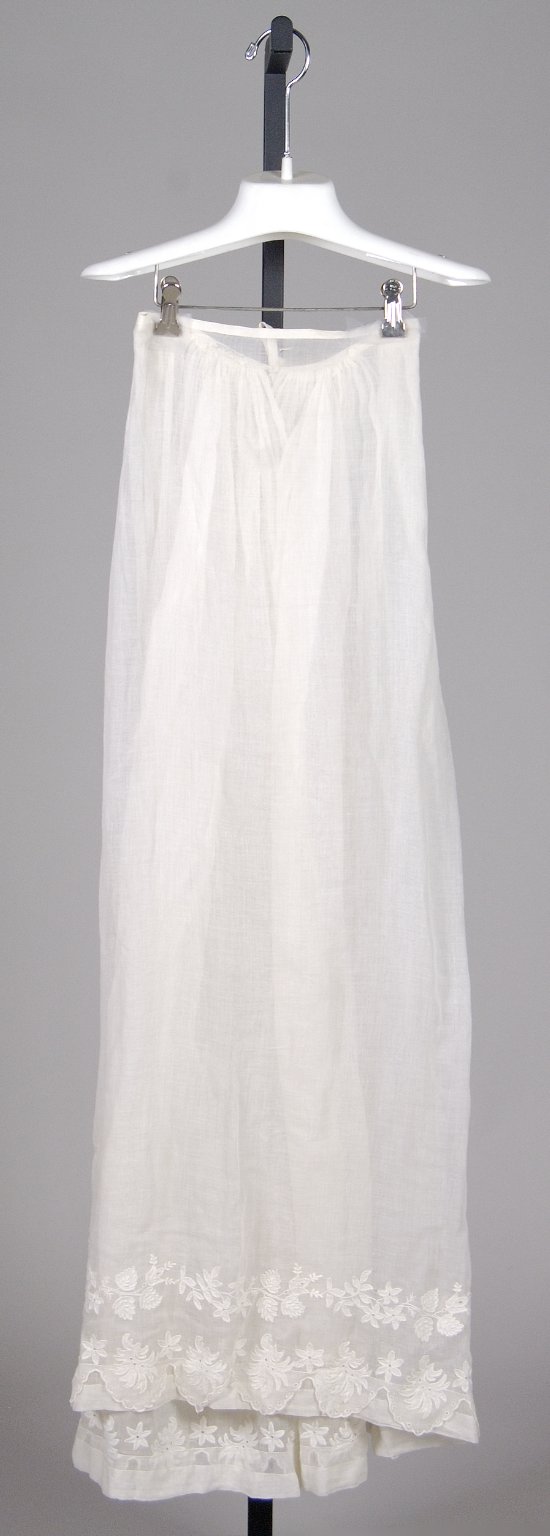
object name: skirt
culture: british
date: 1815-1820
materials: cotton